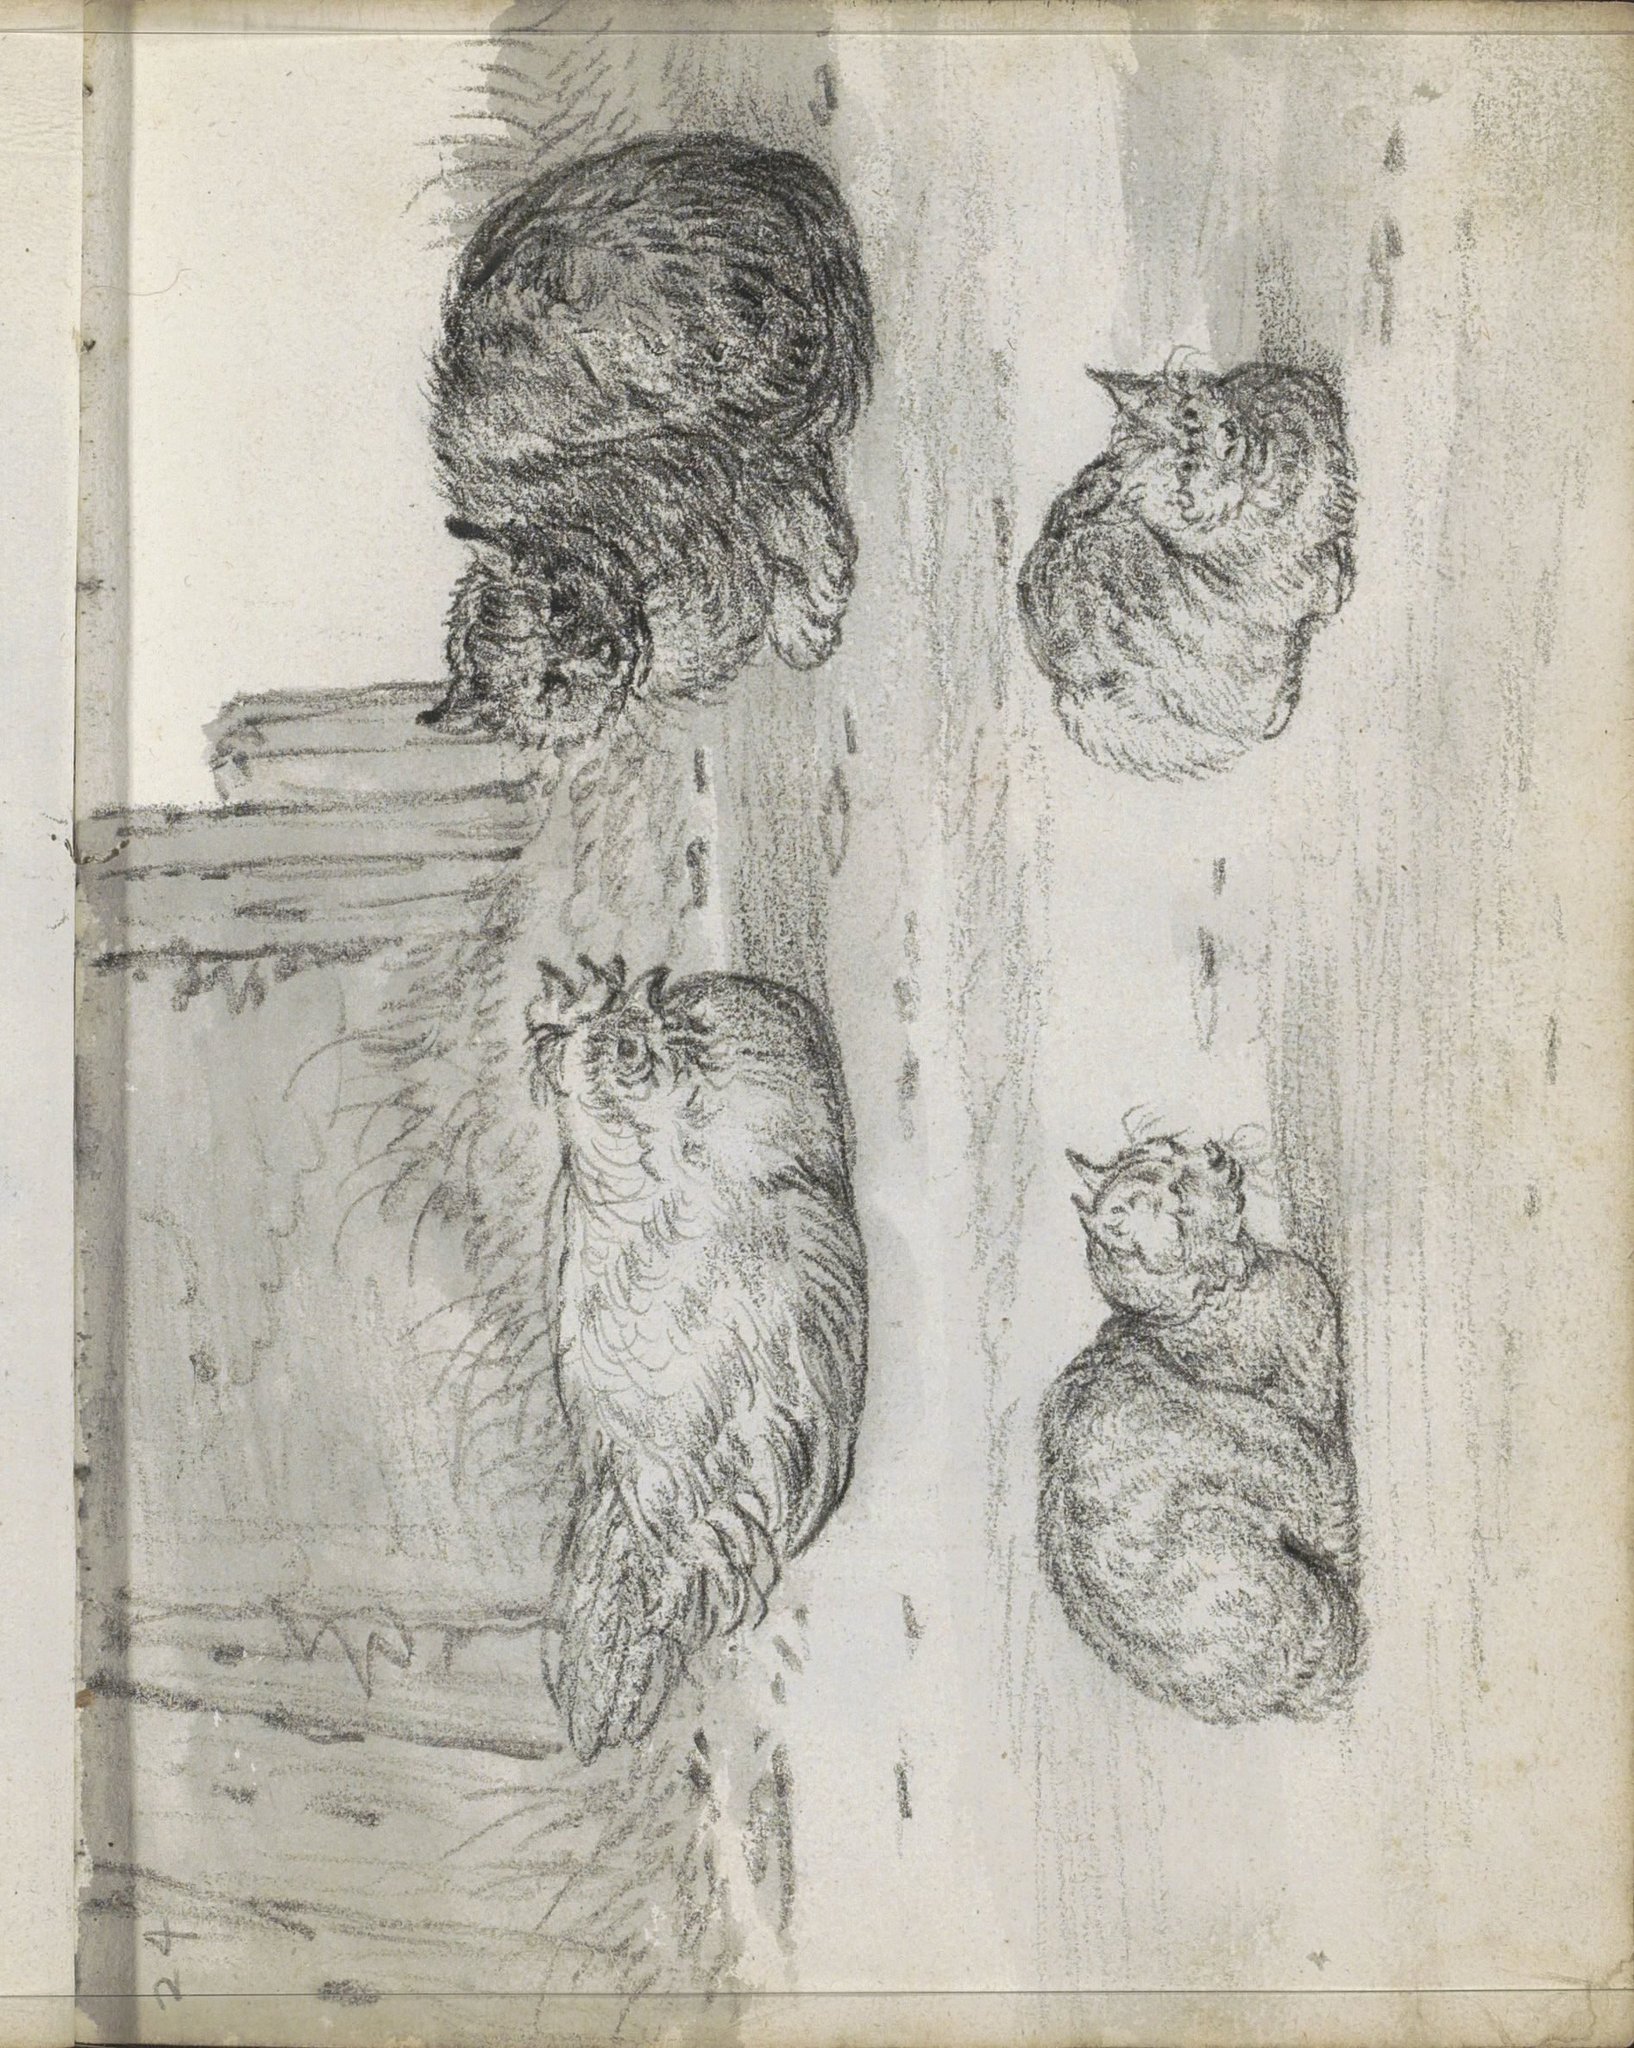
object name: sketchbook leaf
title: Kip en drie katten op een erf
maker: cornelis saftleven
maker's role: draughtsman, painter, print maker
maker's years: 1607-1681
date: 1666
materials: chalk, ink, paper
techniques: brush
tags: cat, fowl (cock, hen, chicken, etc.)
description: Blad 24 recto uit een schetsboek met 49 bladen.